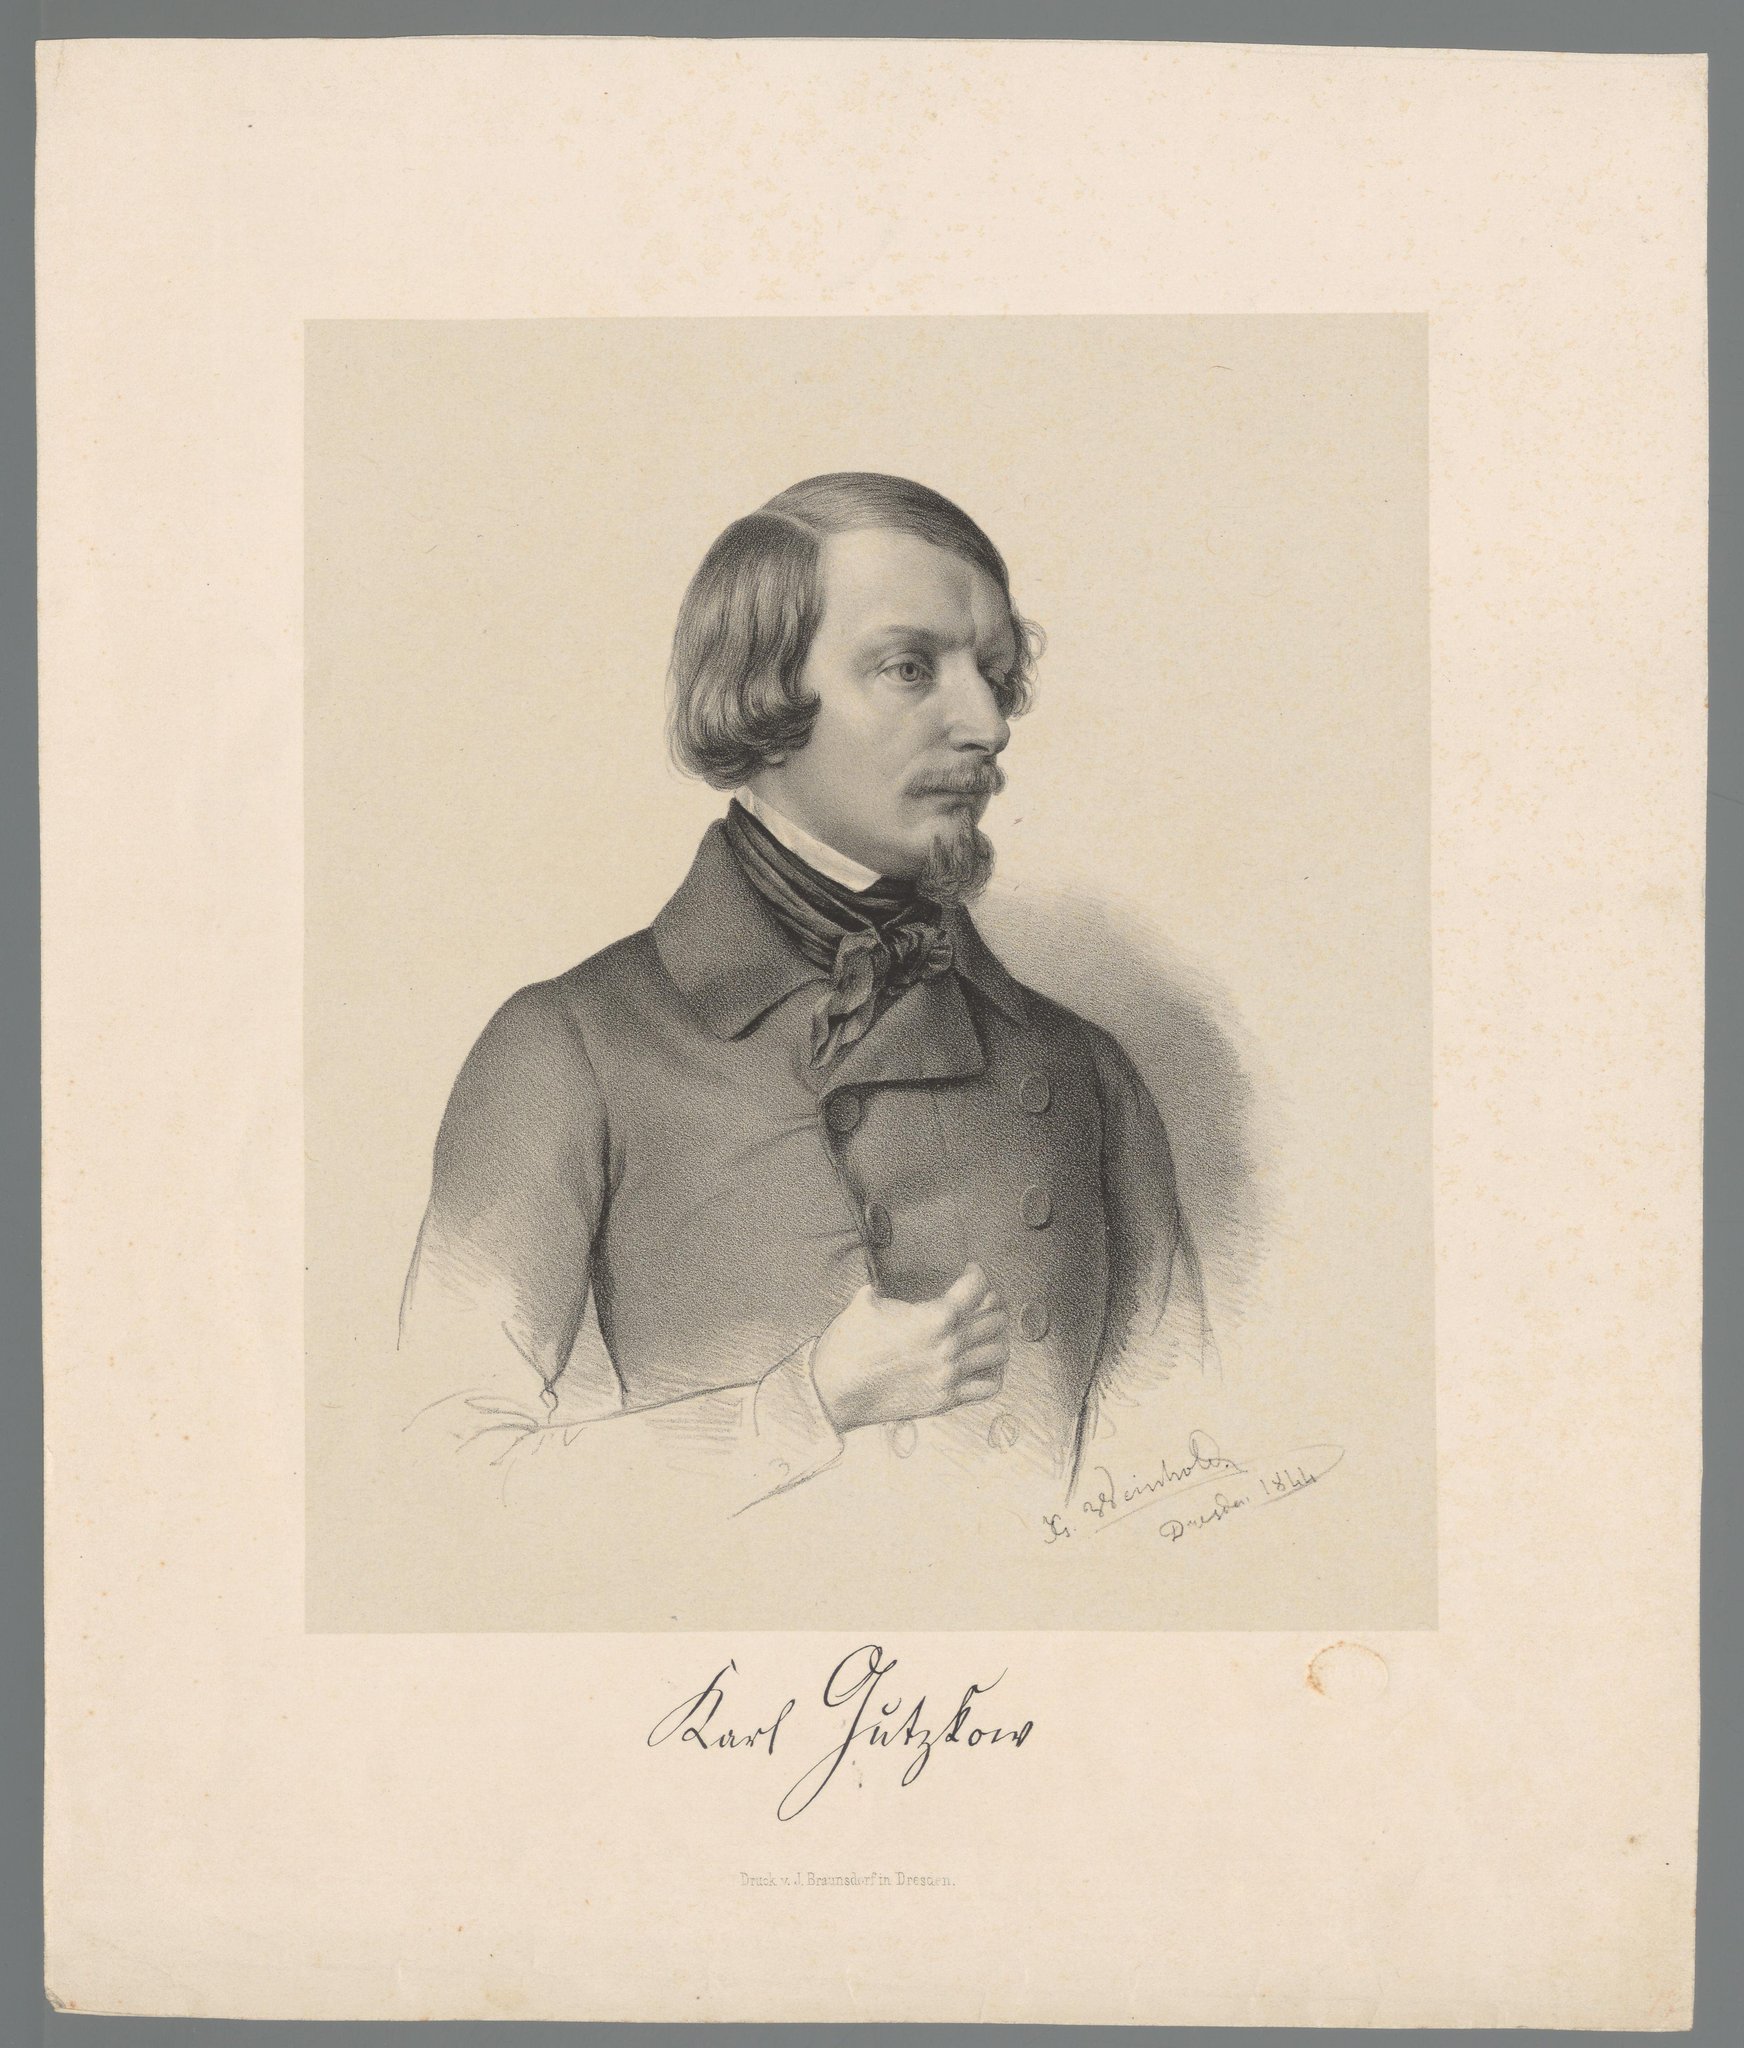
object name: print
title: Portret van Karl Gutzkow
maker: johann georg weinhold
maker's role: print maker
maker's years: 1813-1880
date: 1844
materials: paper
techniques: lithograph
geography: dresden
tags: adult man, historical persons, beard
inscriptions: check stamp: ‘B[M]’, collector's mark: Lugt 2228